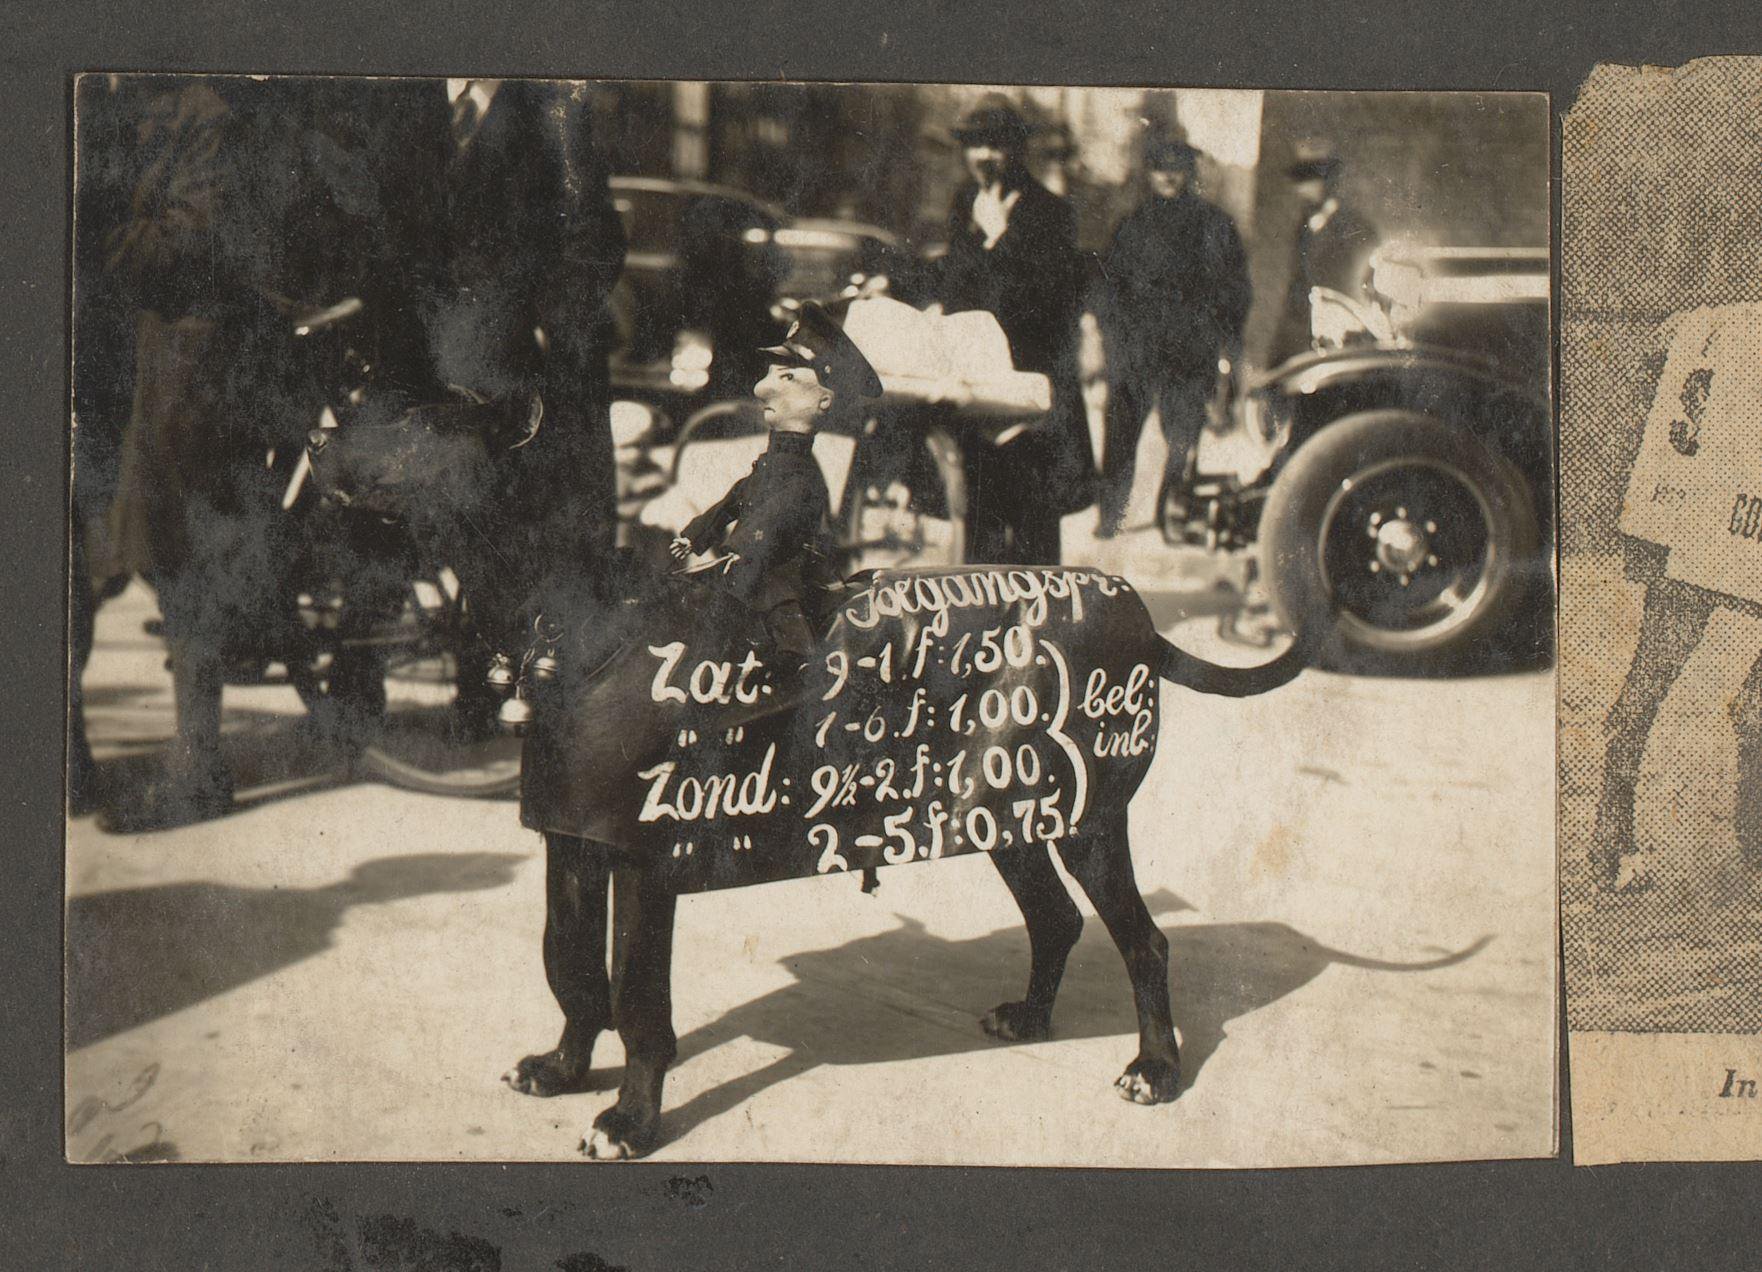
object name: photograph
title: Hond van de poppendokter met reclametekst met een pop op de rug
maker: Anonymous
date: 1930-1940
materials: photographic support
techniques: gelatin silver print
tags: advertising, dolls for adults, dog